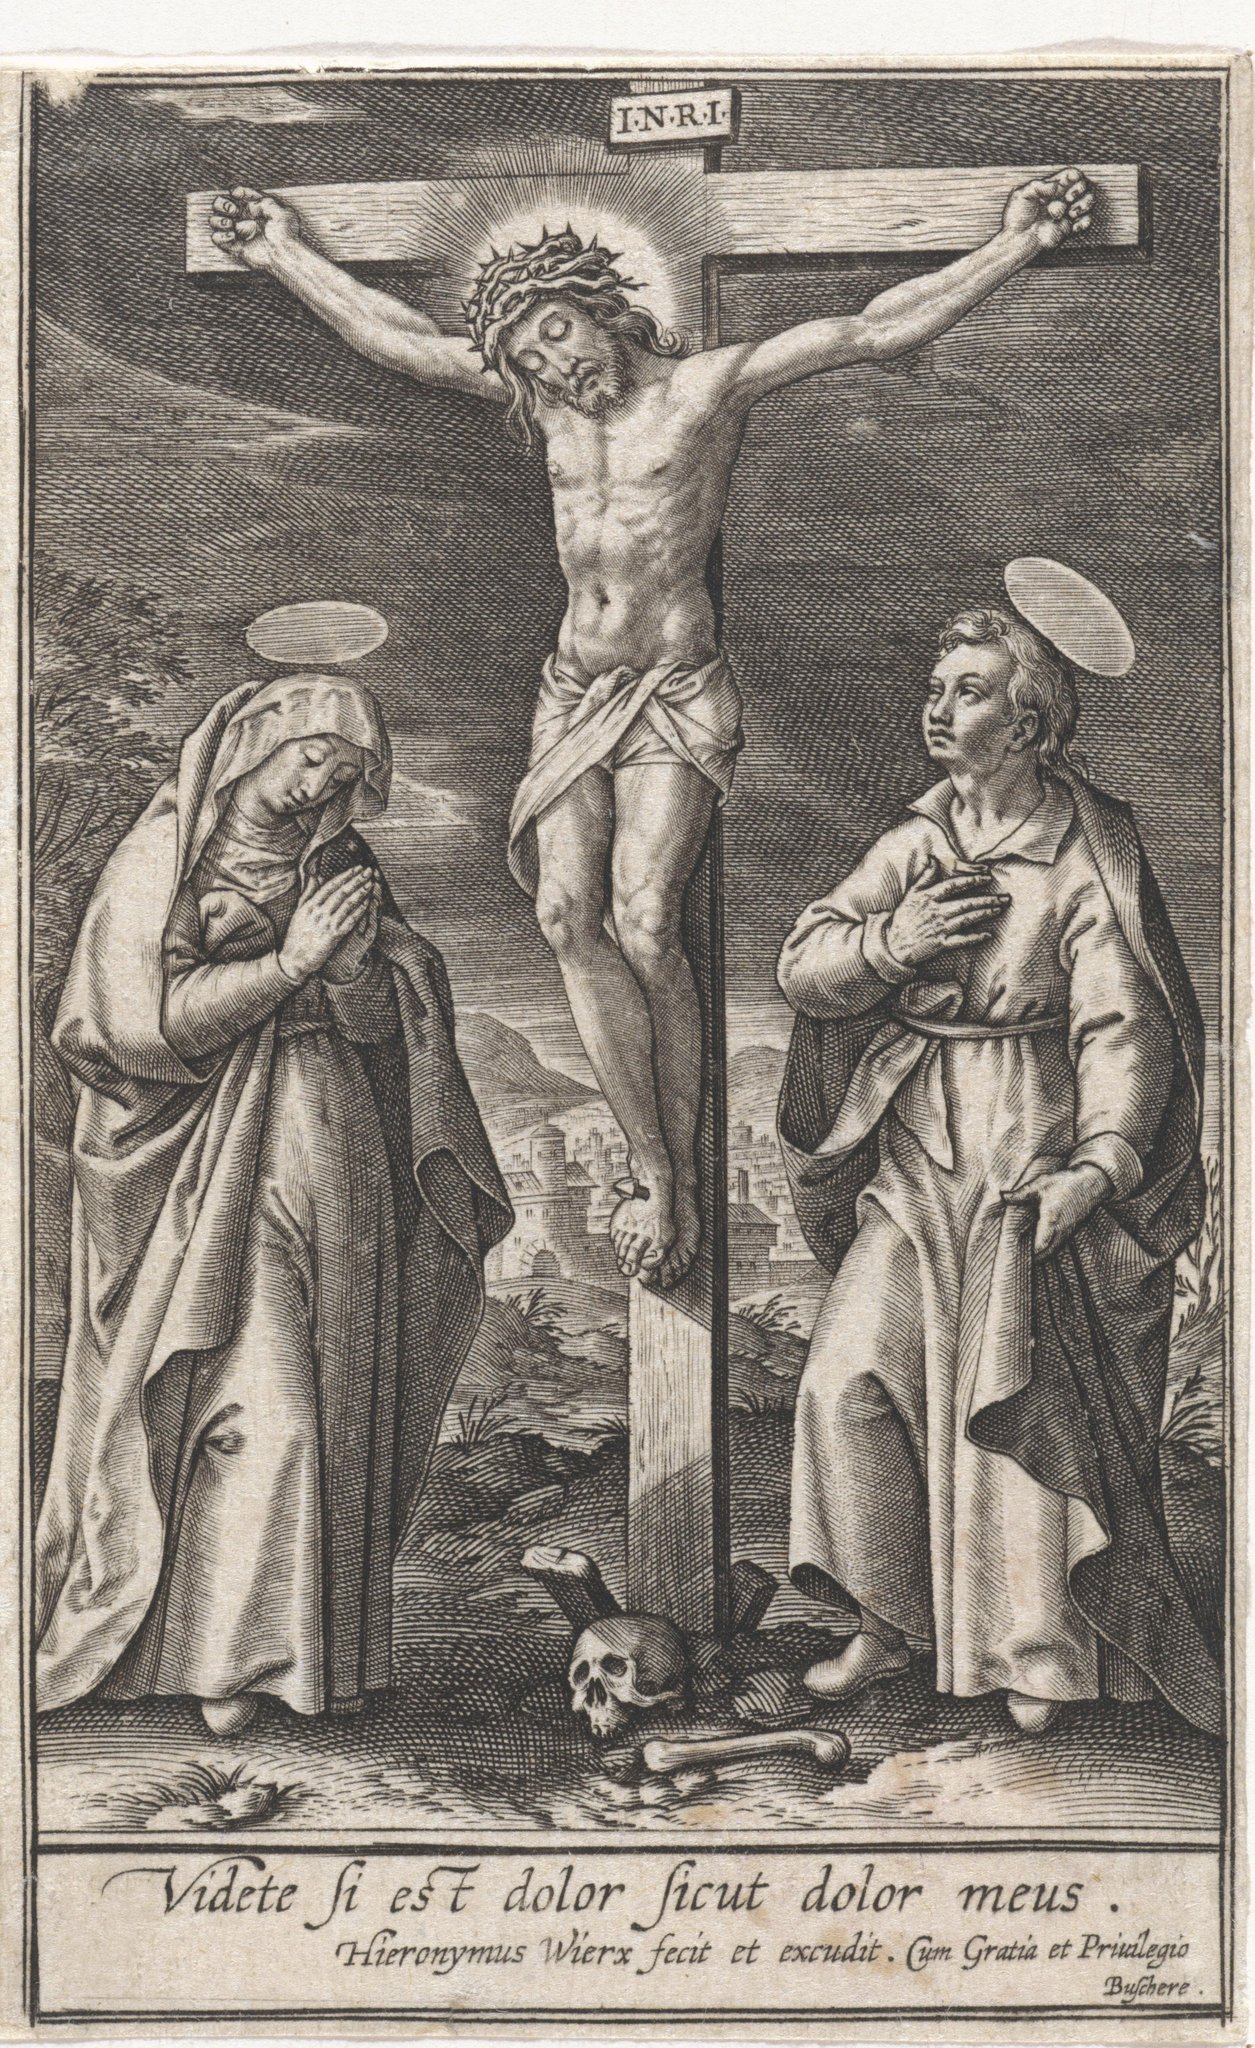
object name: print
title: Kruisiging van Christus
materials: paper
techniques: engraving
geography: antwerp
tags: crucified christ, with particular persons under the cross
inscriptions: number: ‘58’, collector's mark: Lugt 240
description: Christus hangt aan het kruis. Aan de voet van het kruis Maria en Johannes. In de marge een onderschrift in het Latijn.